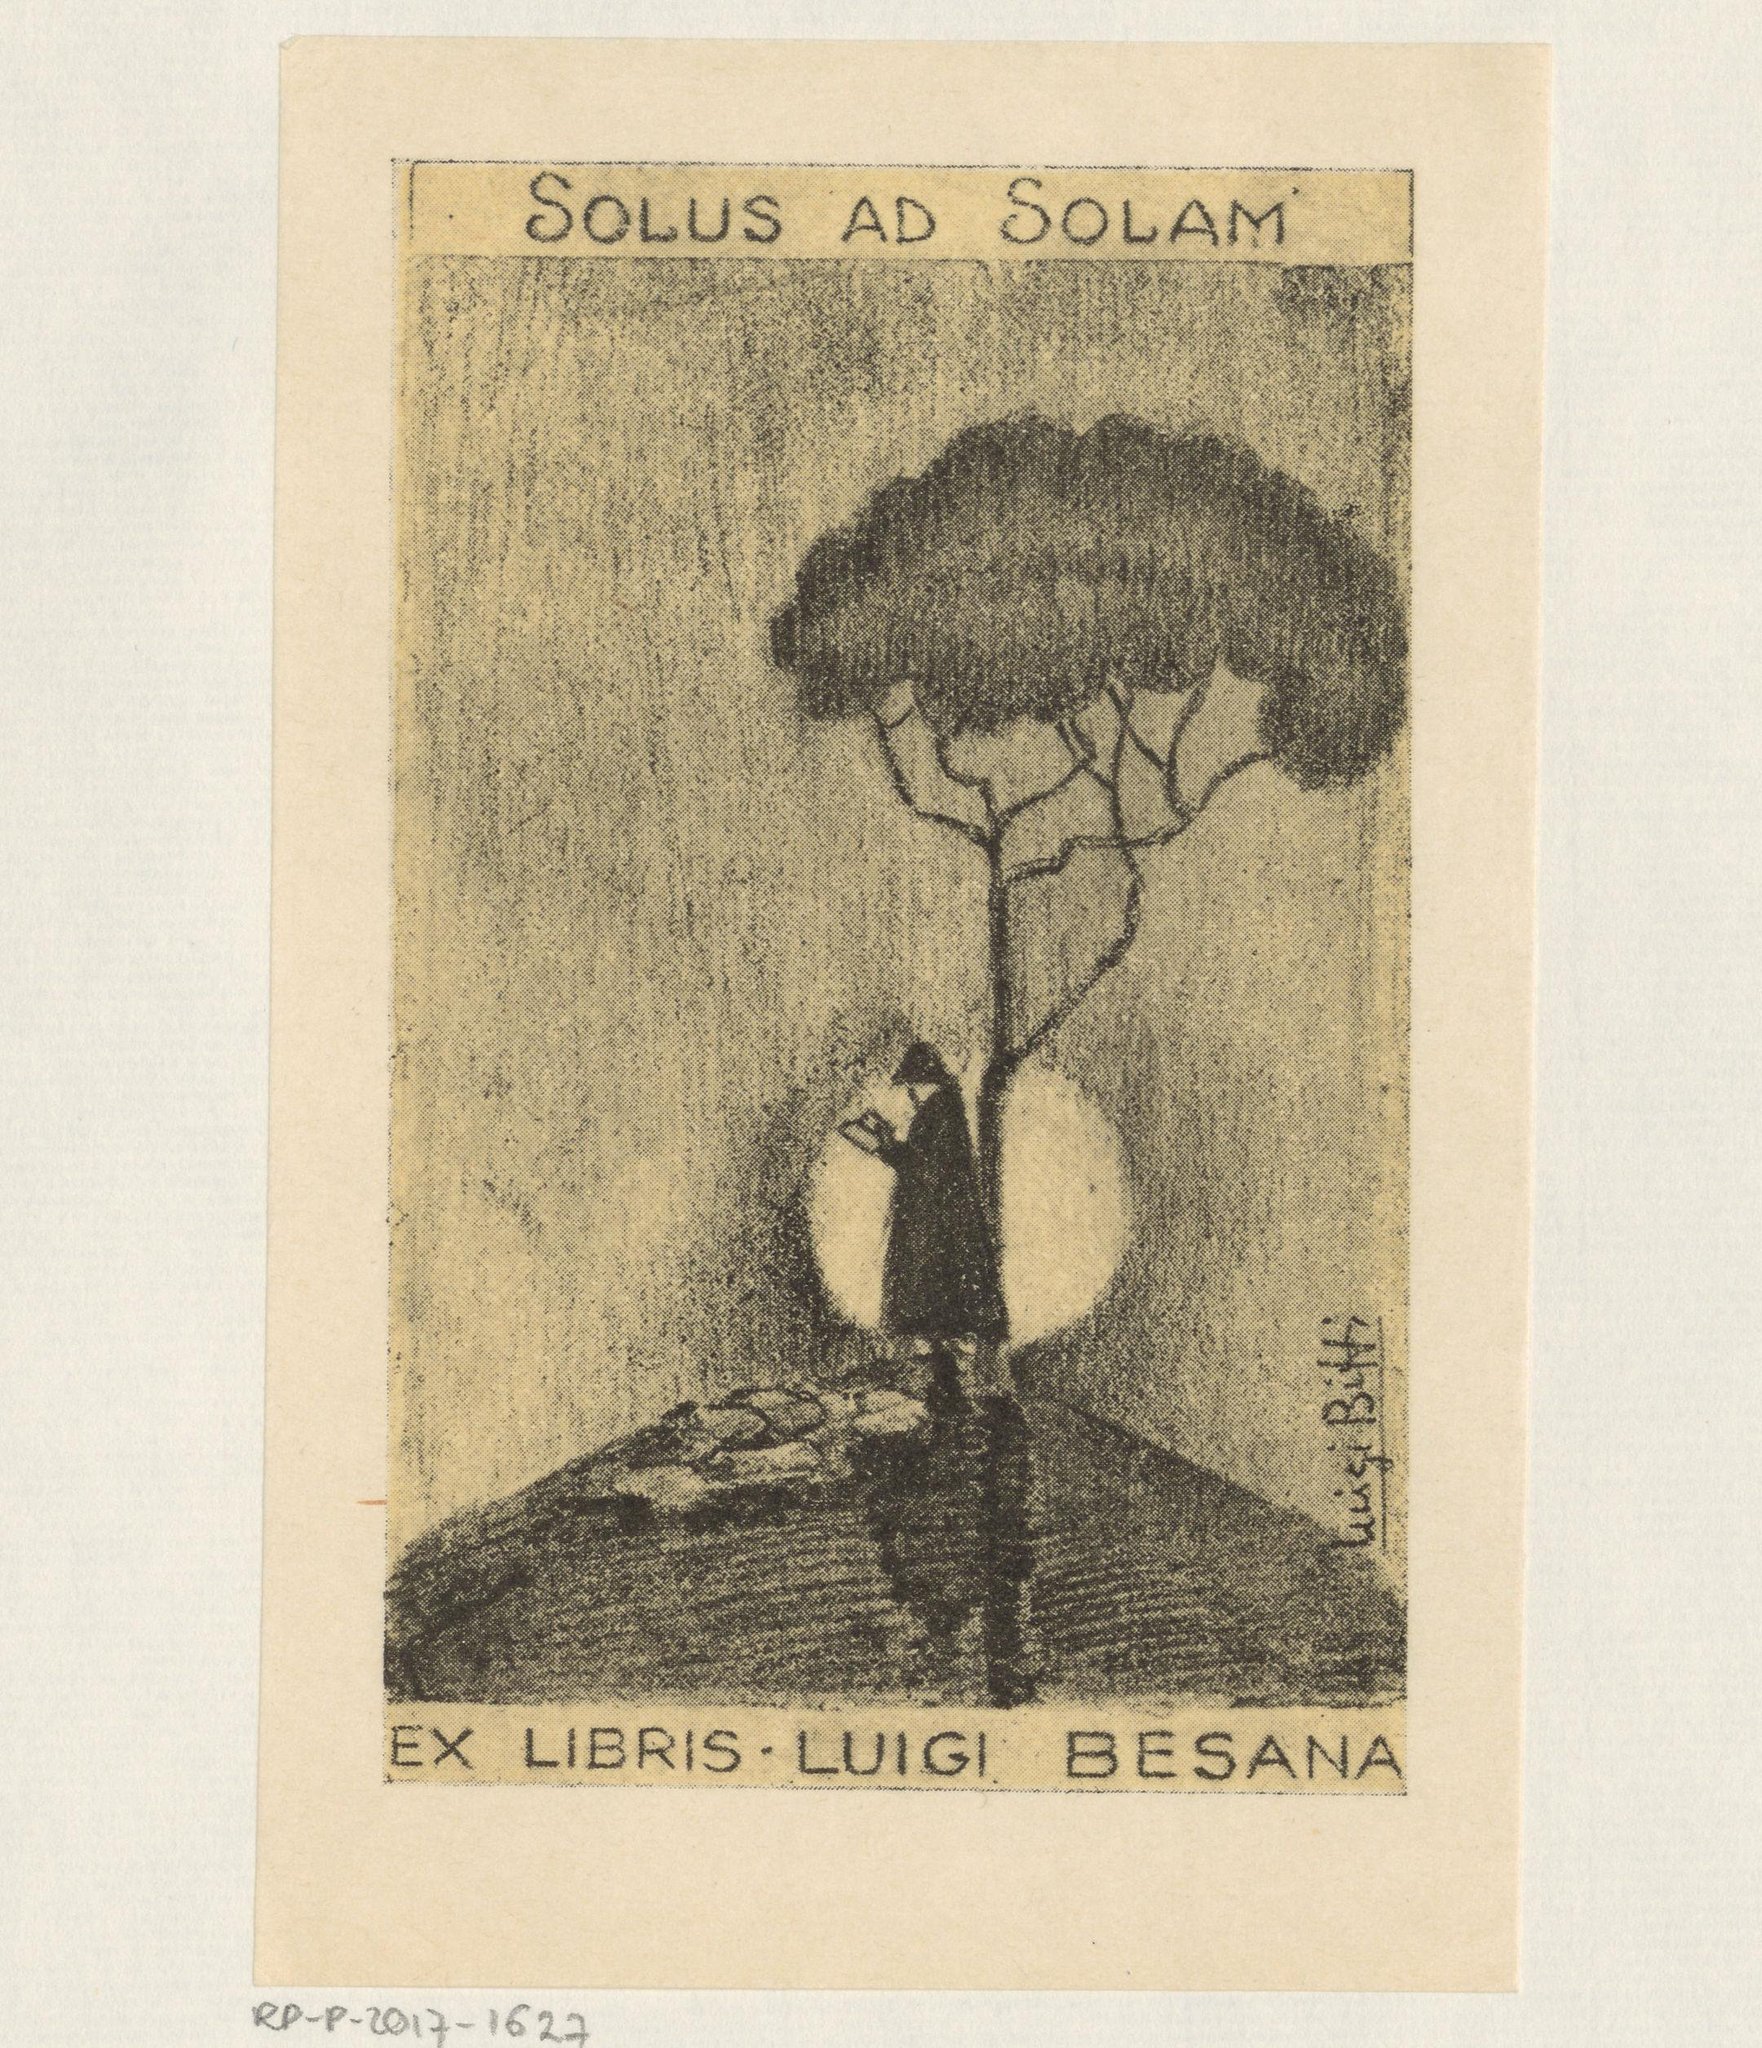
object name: photomechanical print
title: Ex libris van Luigi Besana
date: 1940-1950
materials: paper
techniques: autotype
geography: italy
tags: standing figure, trees, reading